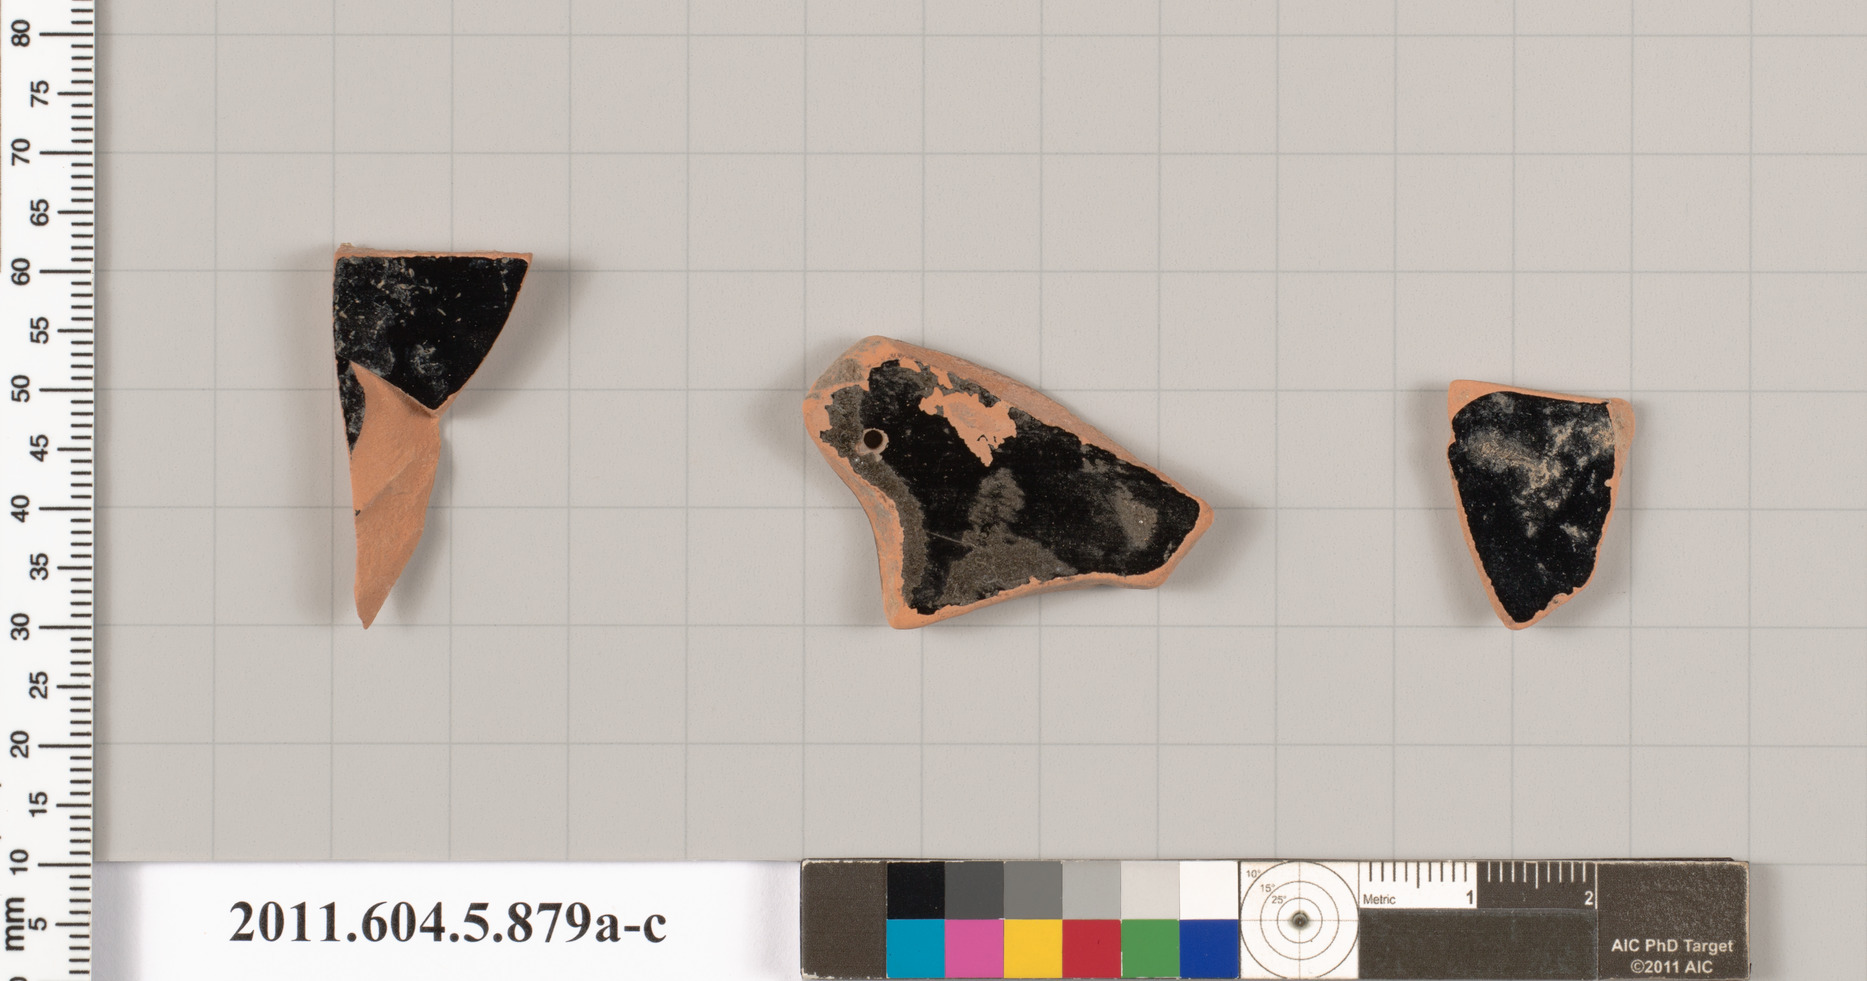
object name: kylix fragment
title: Terracotta fragments of kylikes (drinking cups)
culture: greek, attic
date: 600-401 BCE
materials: terracotta